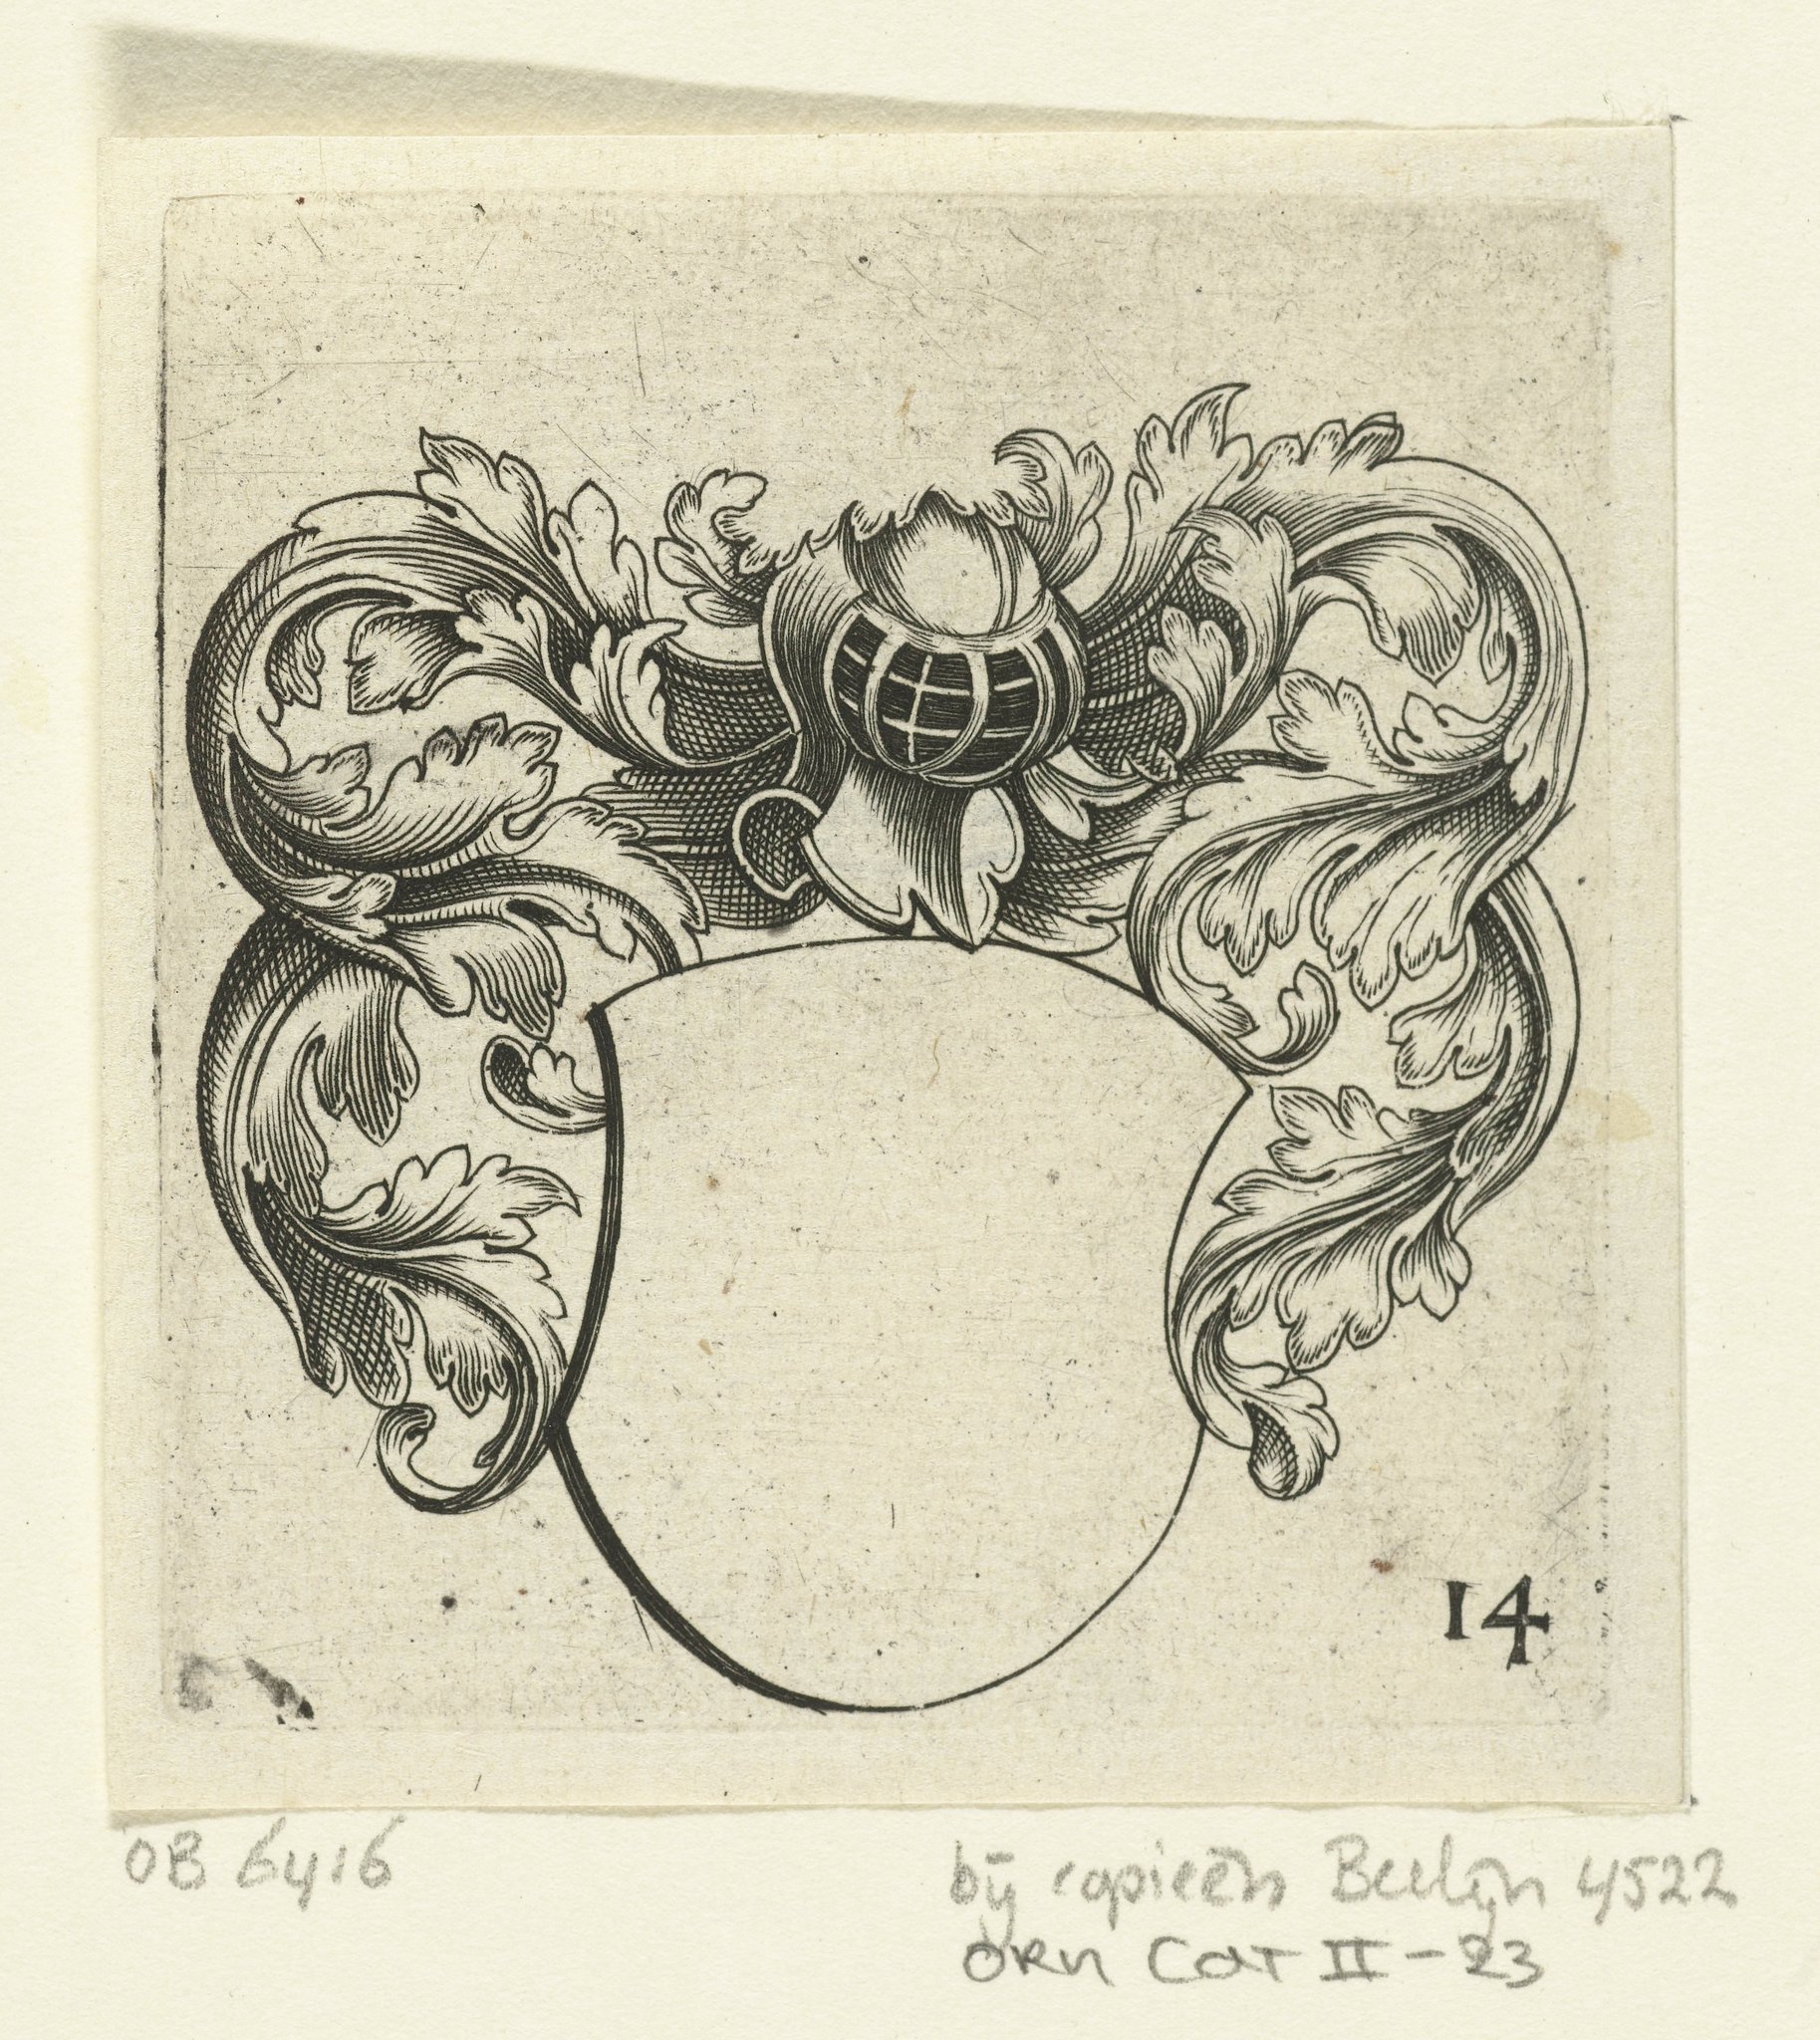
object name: print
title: Wapenschild met een helm en bladranken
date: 1625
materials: paper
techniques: engraving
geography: amsterdam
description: De helm wijst naar rechts. Blad uit serie wapenschilden met lege compartimenten.